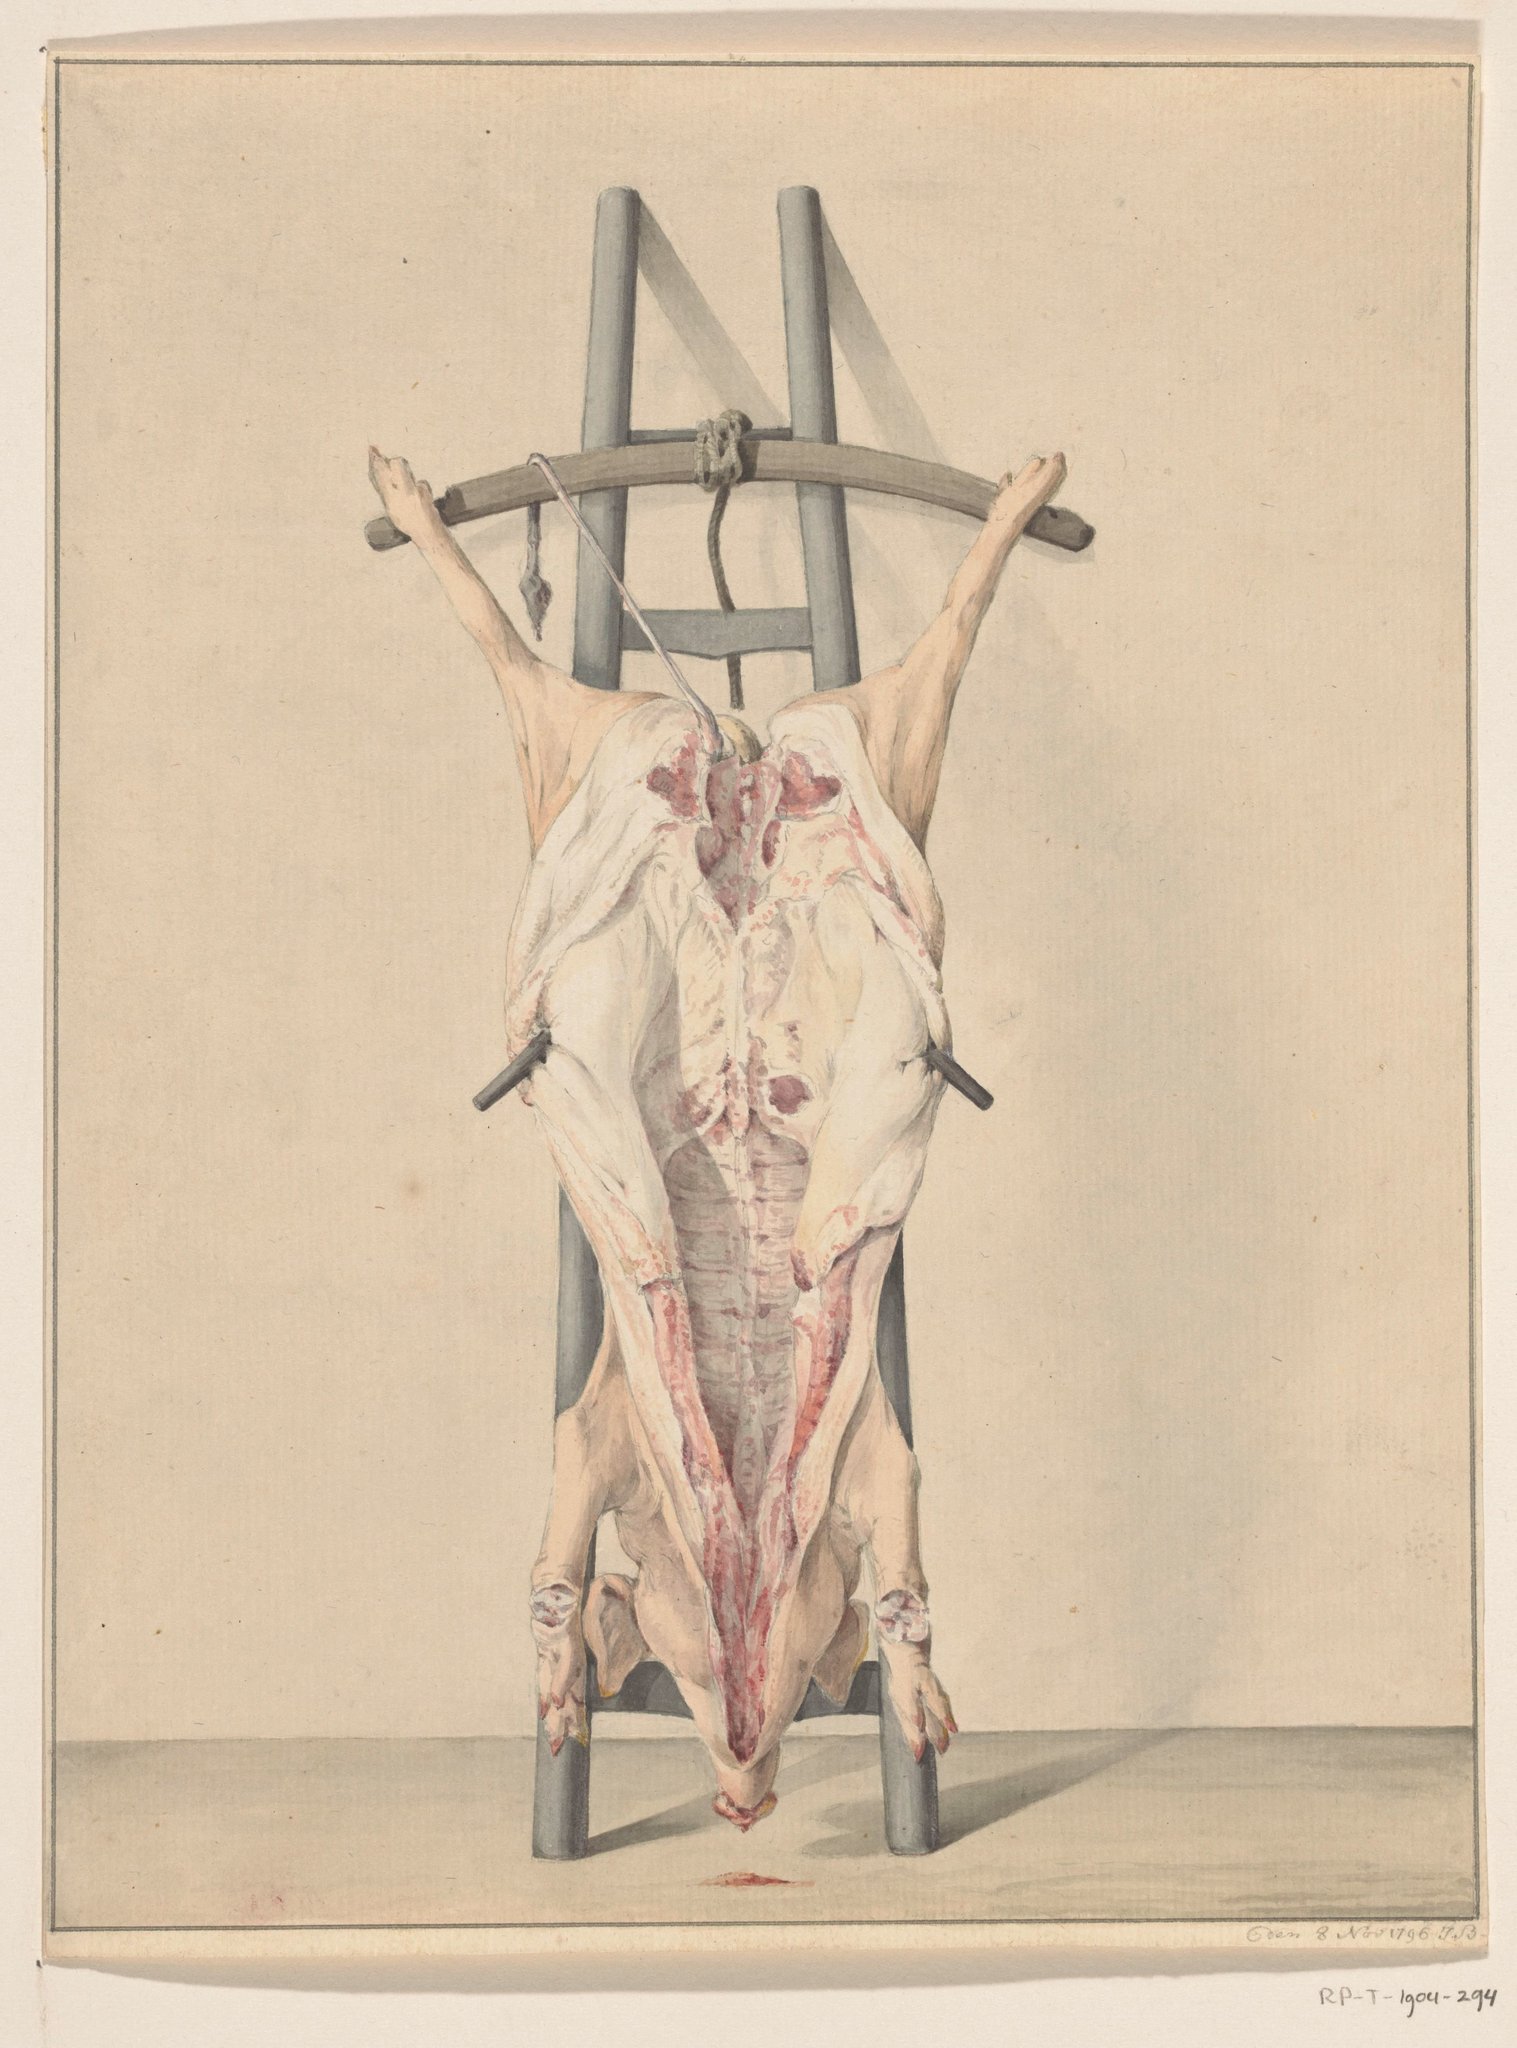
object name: watercolor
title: Geslacht varken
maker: jean bernard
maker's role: draughtsman, print maker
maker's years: 1765-1833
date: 1796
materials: chalk, paper, watercolor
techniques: brush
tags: pig (+ slaughtered animal)